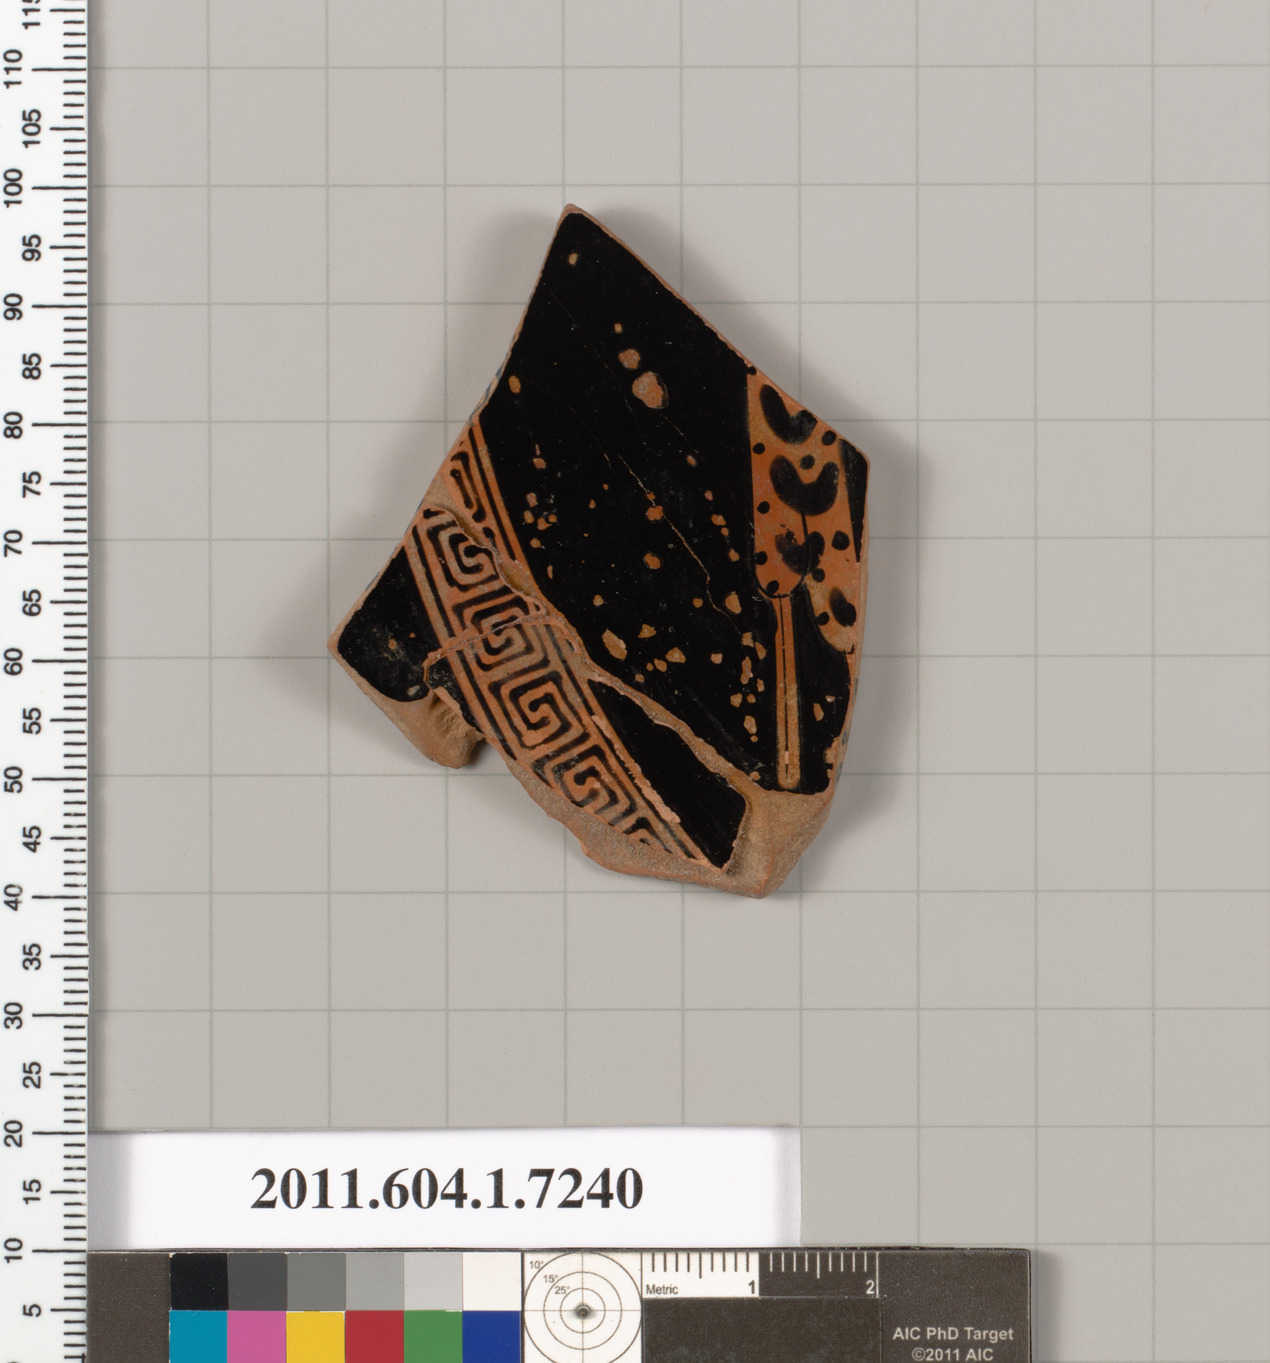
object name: kylix fragment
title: Terracotta fragment of a kylix (drinking cup)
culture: greek, attic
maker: makron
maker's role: artist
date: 500-480 BCE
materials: terracotta